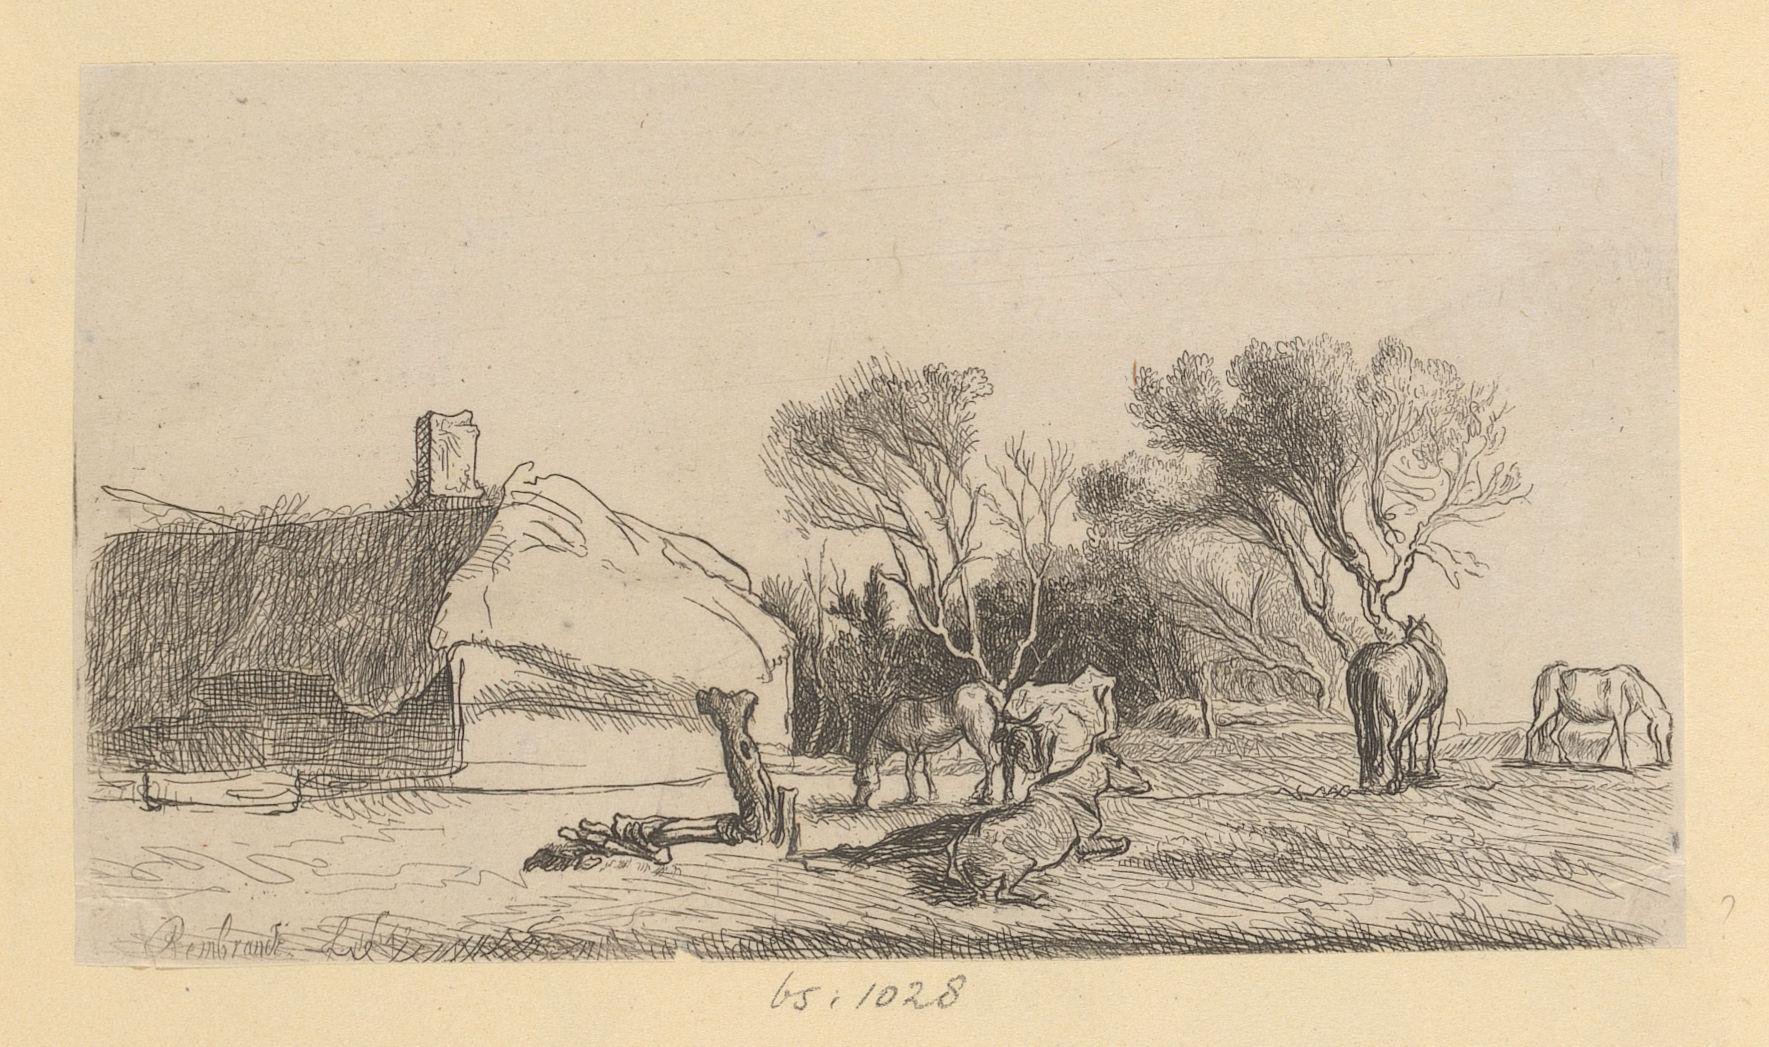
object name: album leaf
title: Landschap met paarden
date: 1750-1799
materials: paper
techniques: etching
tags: horse, meadow, pasture (+ landscape with figures, staffage)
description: Prent maakt mogelijk deel uit van een serie van 200 prenten. Deze serie is onder de titel 'A Collection of two hundred original etchings' voor het eerst uitgegeven door J.M. Greery in 1816.